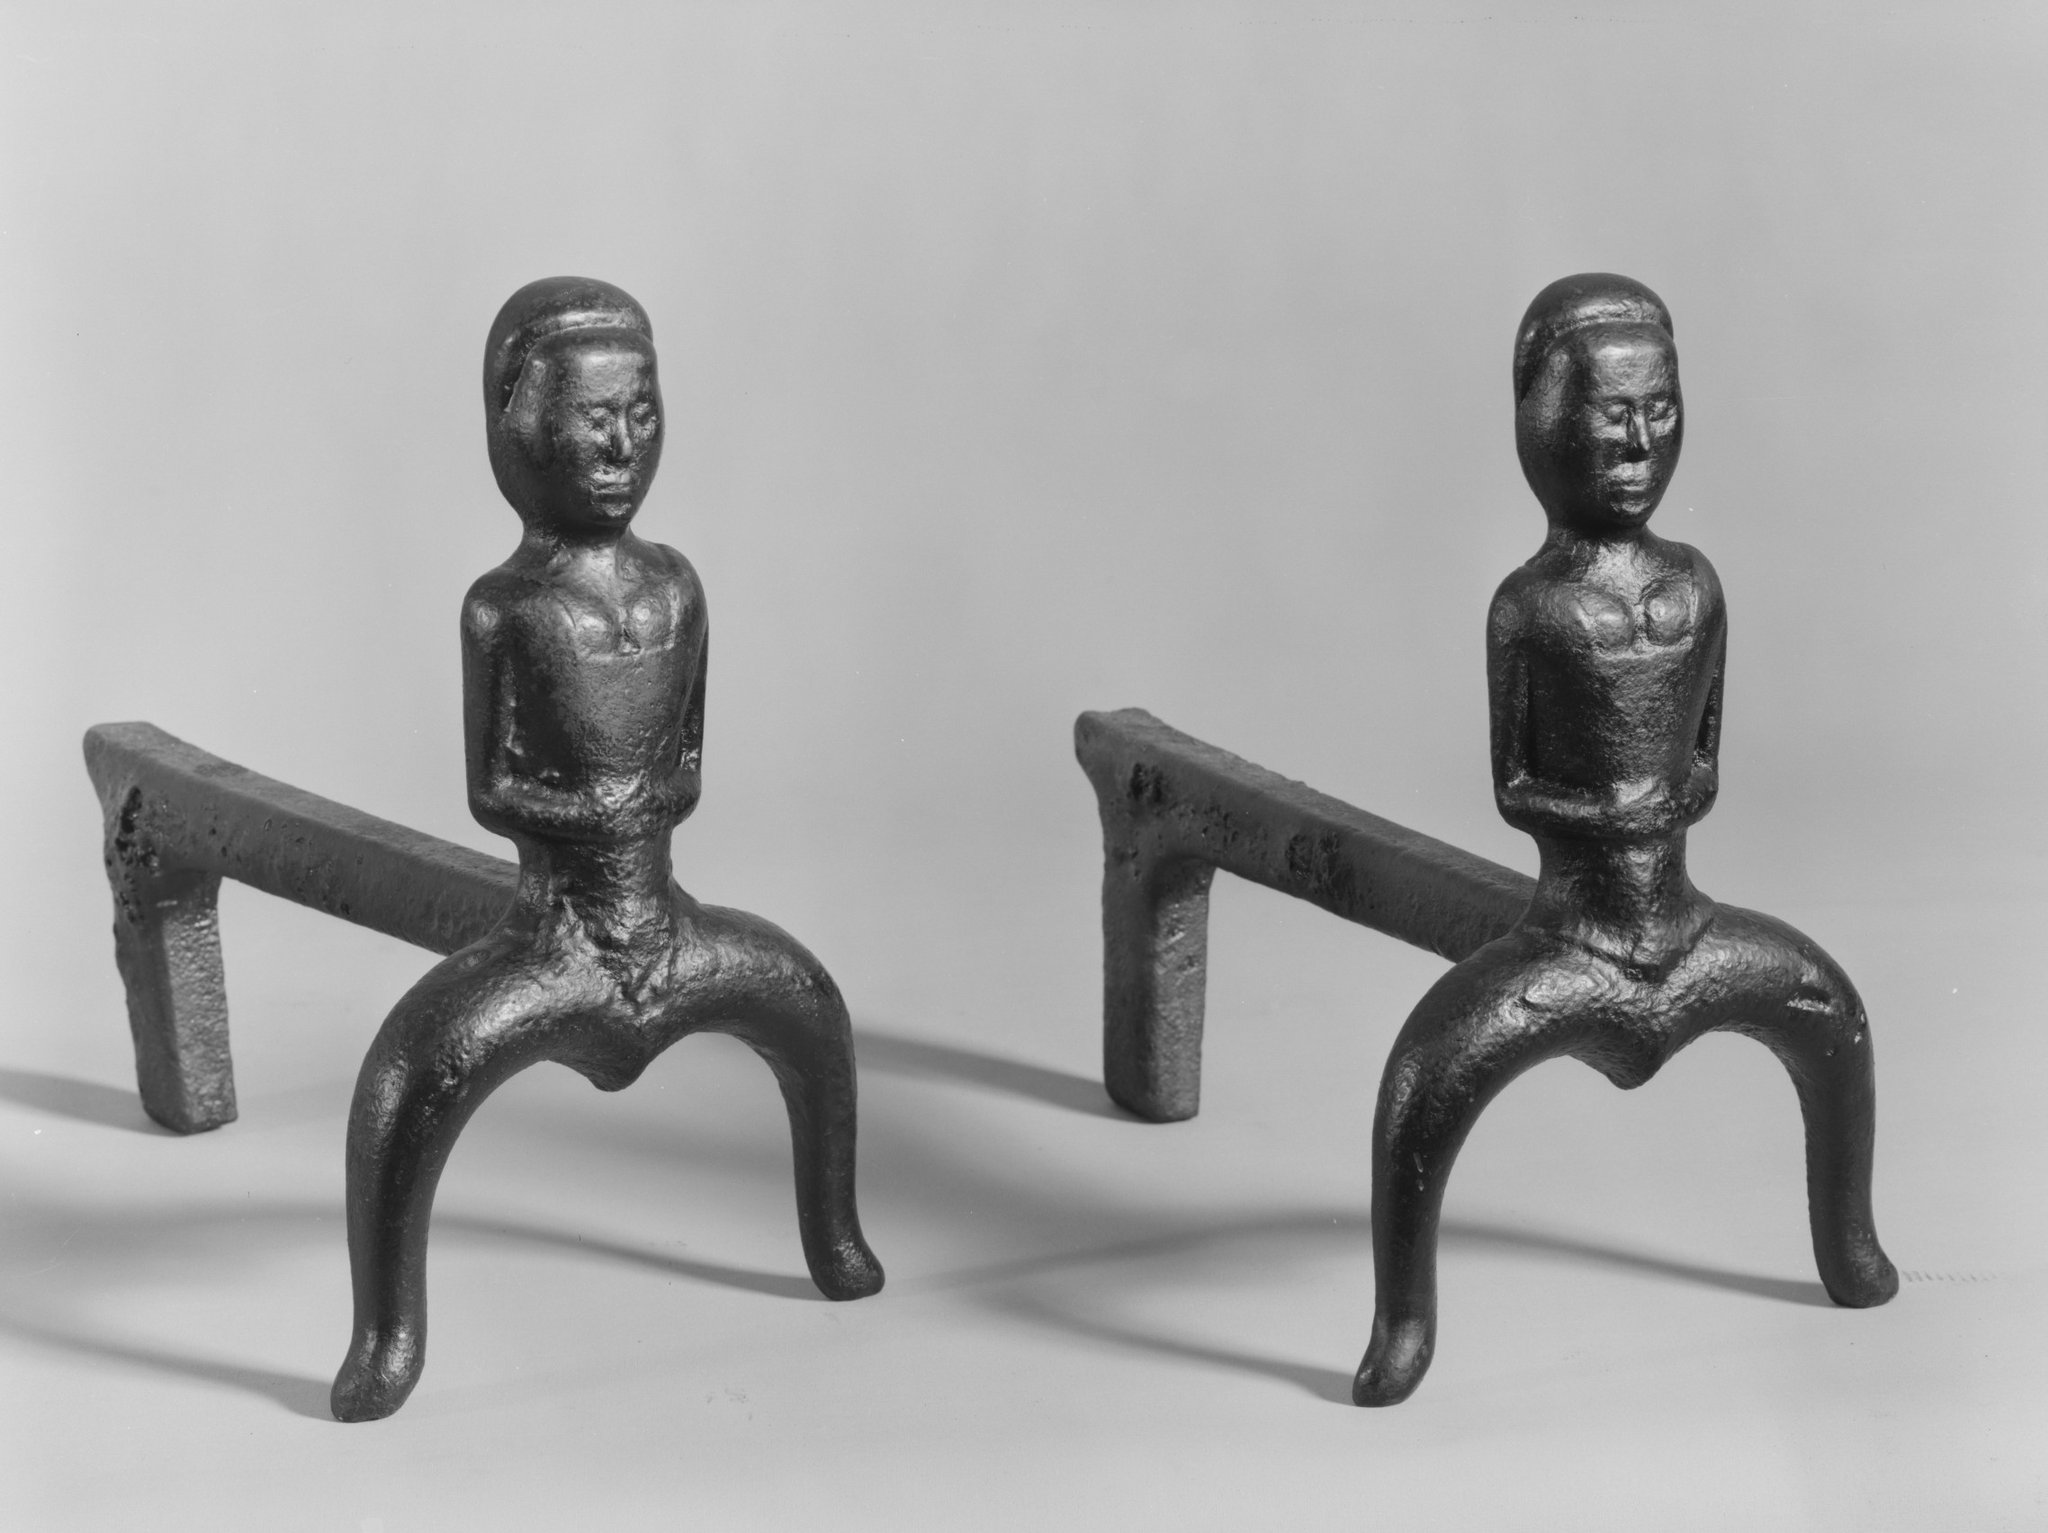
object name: andiron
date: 1770-1800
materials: iron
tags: human figures